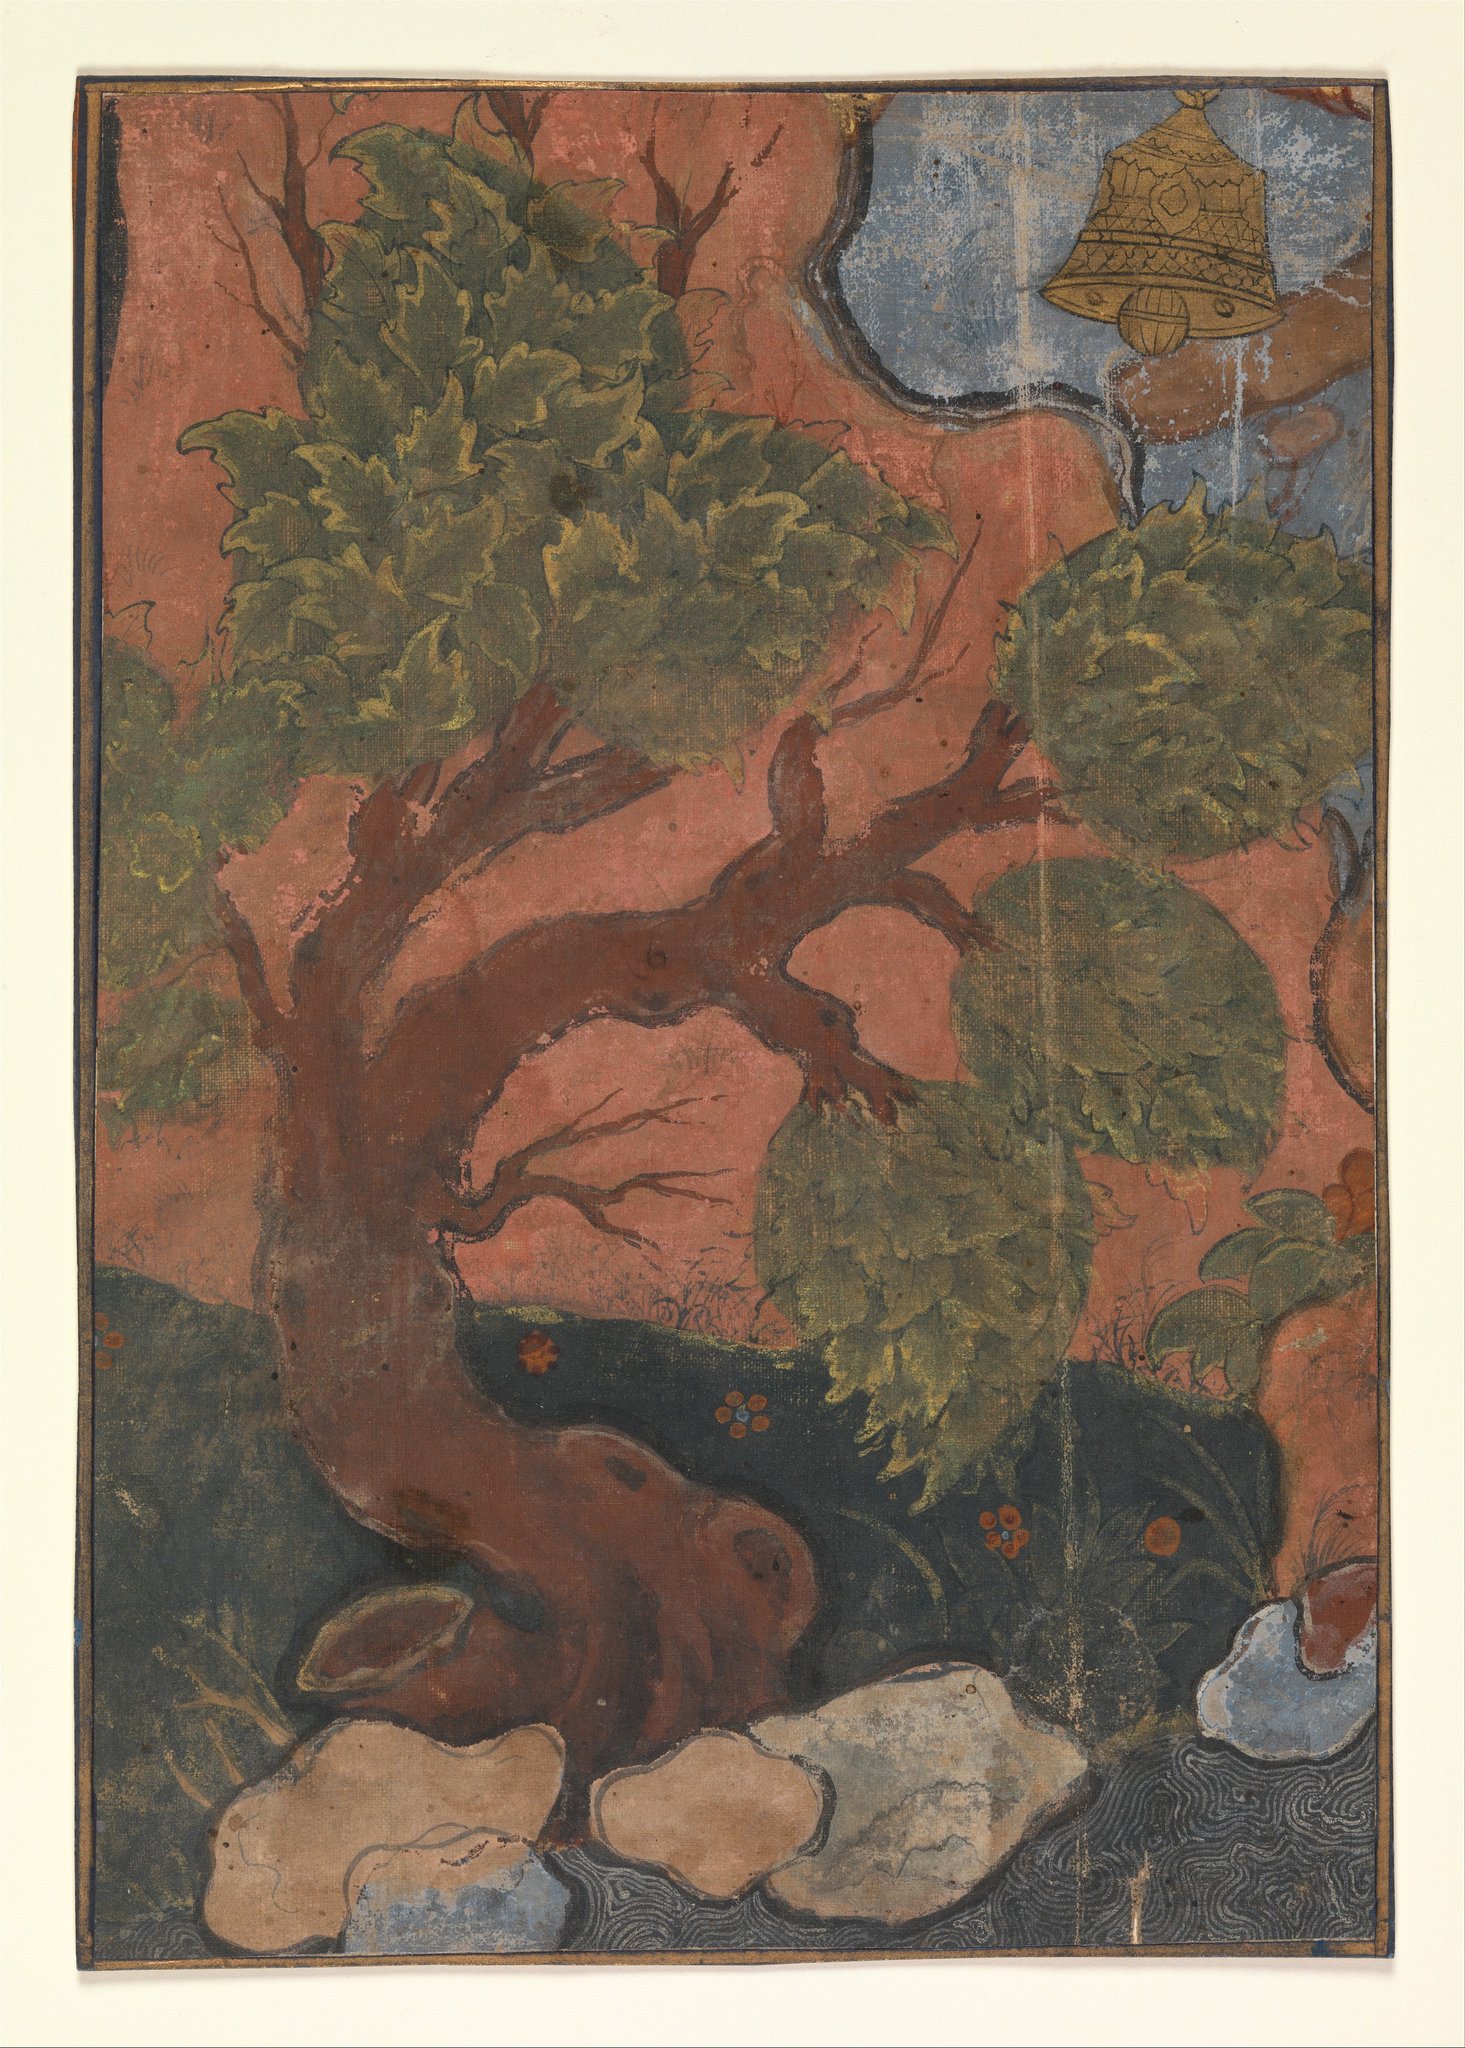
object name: illustrated album leaf or single work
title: Tree on a River Bank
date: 1501-1600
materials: cotton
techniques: painting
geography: india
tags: rivers,trees